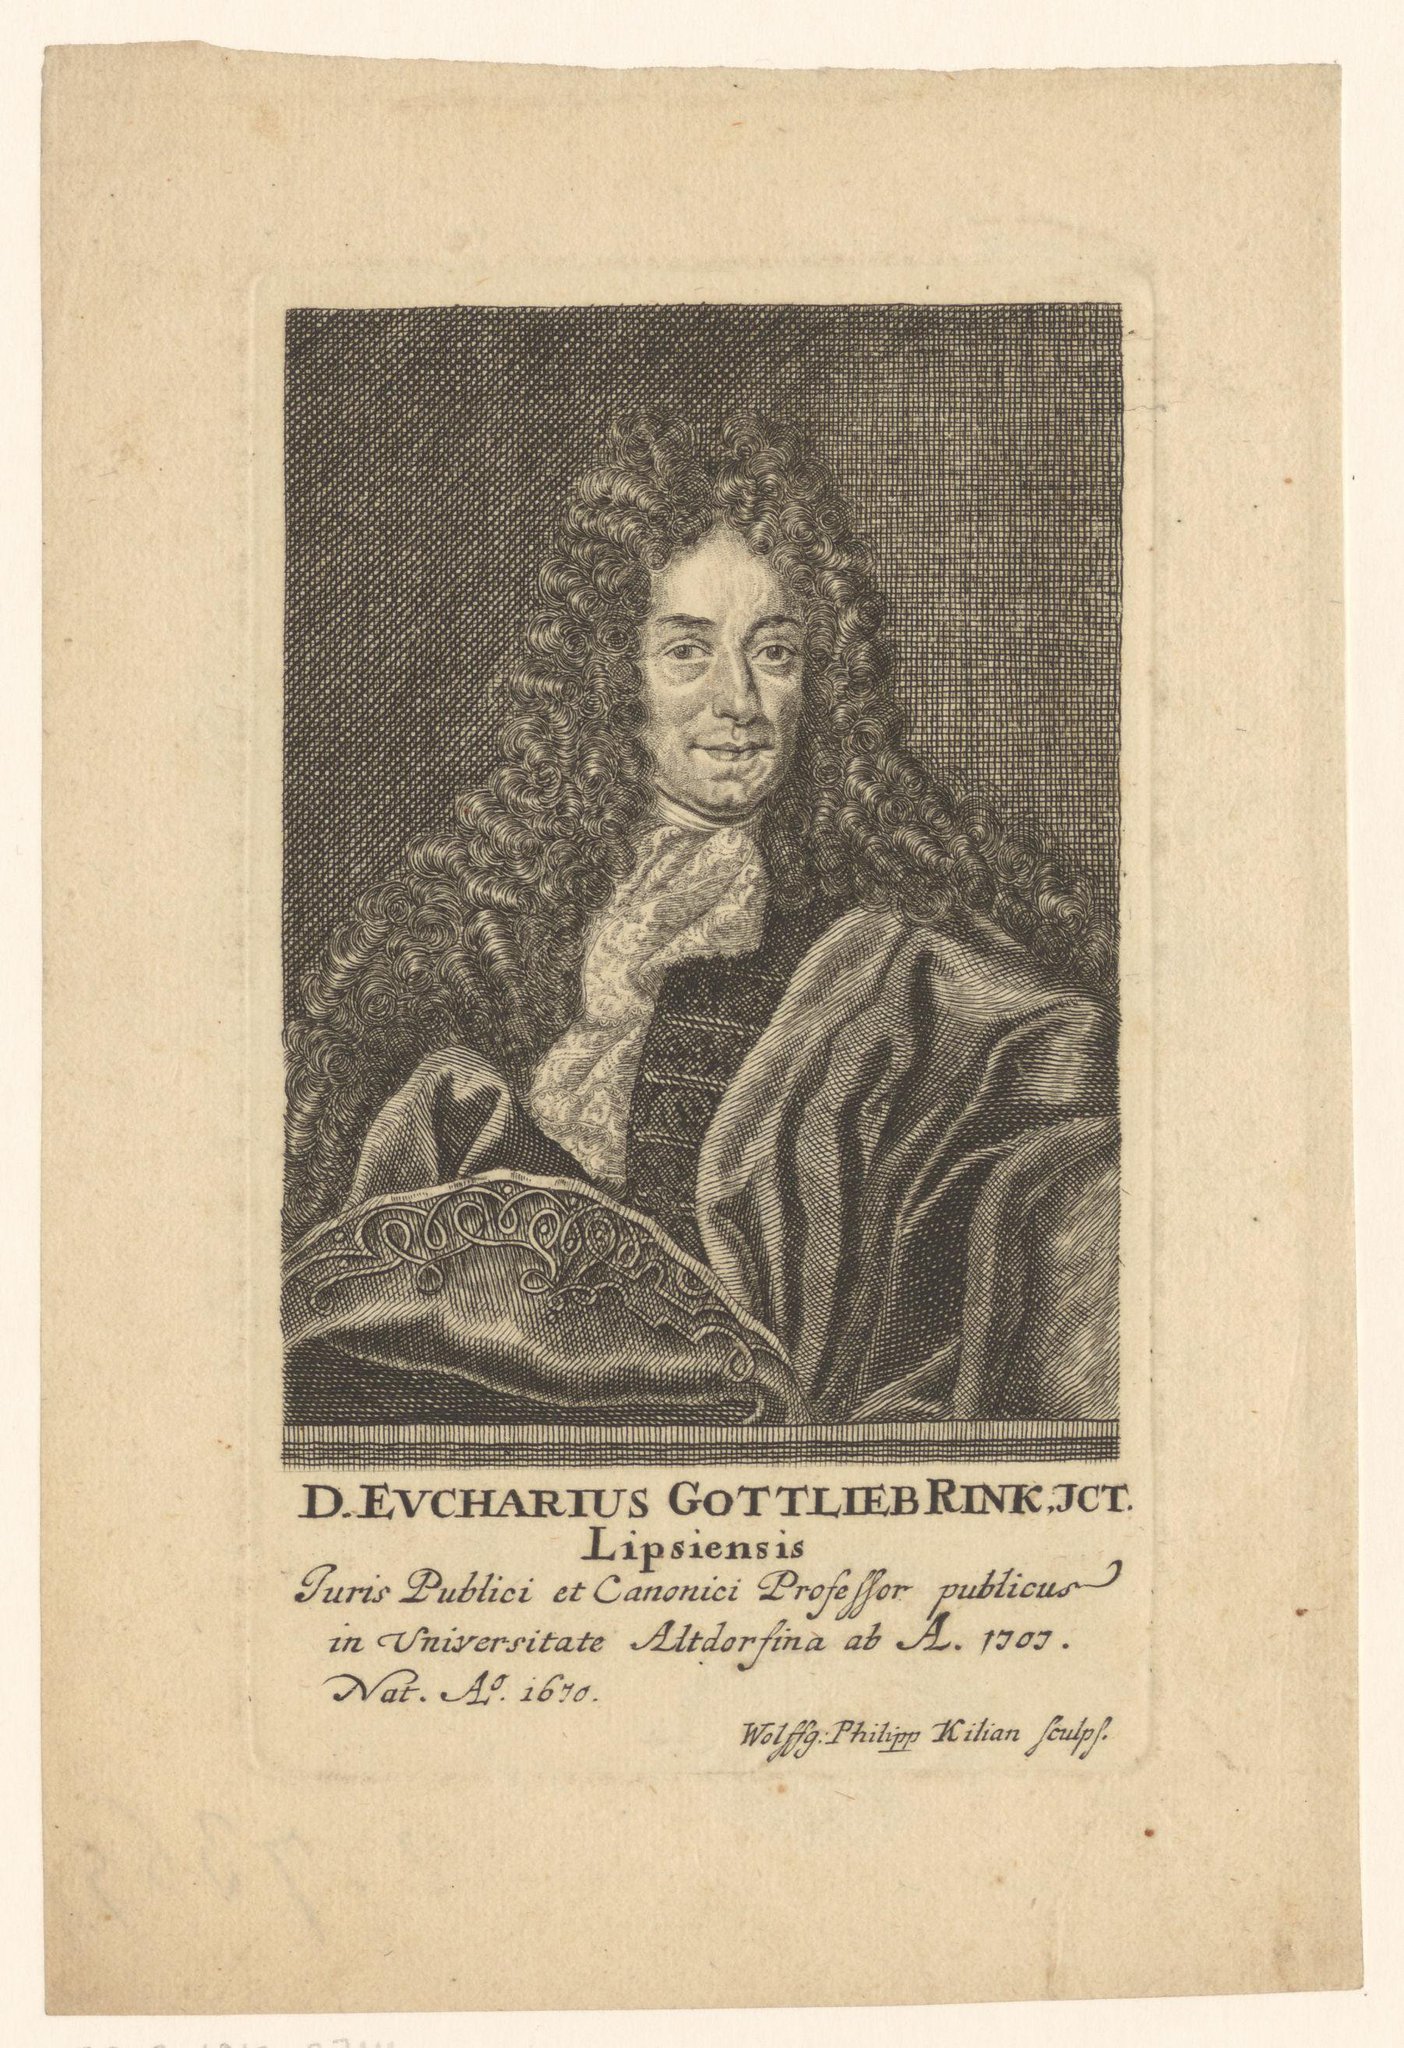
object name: print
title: Portret van Eucharius Gottlieb Rinck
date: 1707-1732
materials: paper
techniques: engraving, etching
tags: history and archaeology (+ portrait of scholar, scientist), further education (+ portrait of teacher, professor), historical persons, lawyer, attorney at law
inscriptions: collector's mark: Lugt 358, collector's mark: Lugt 2228